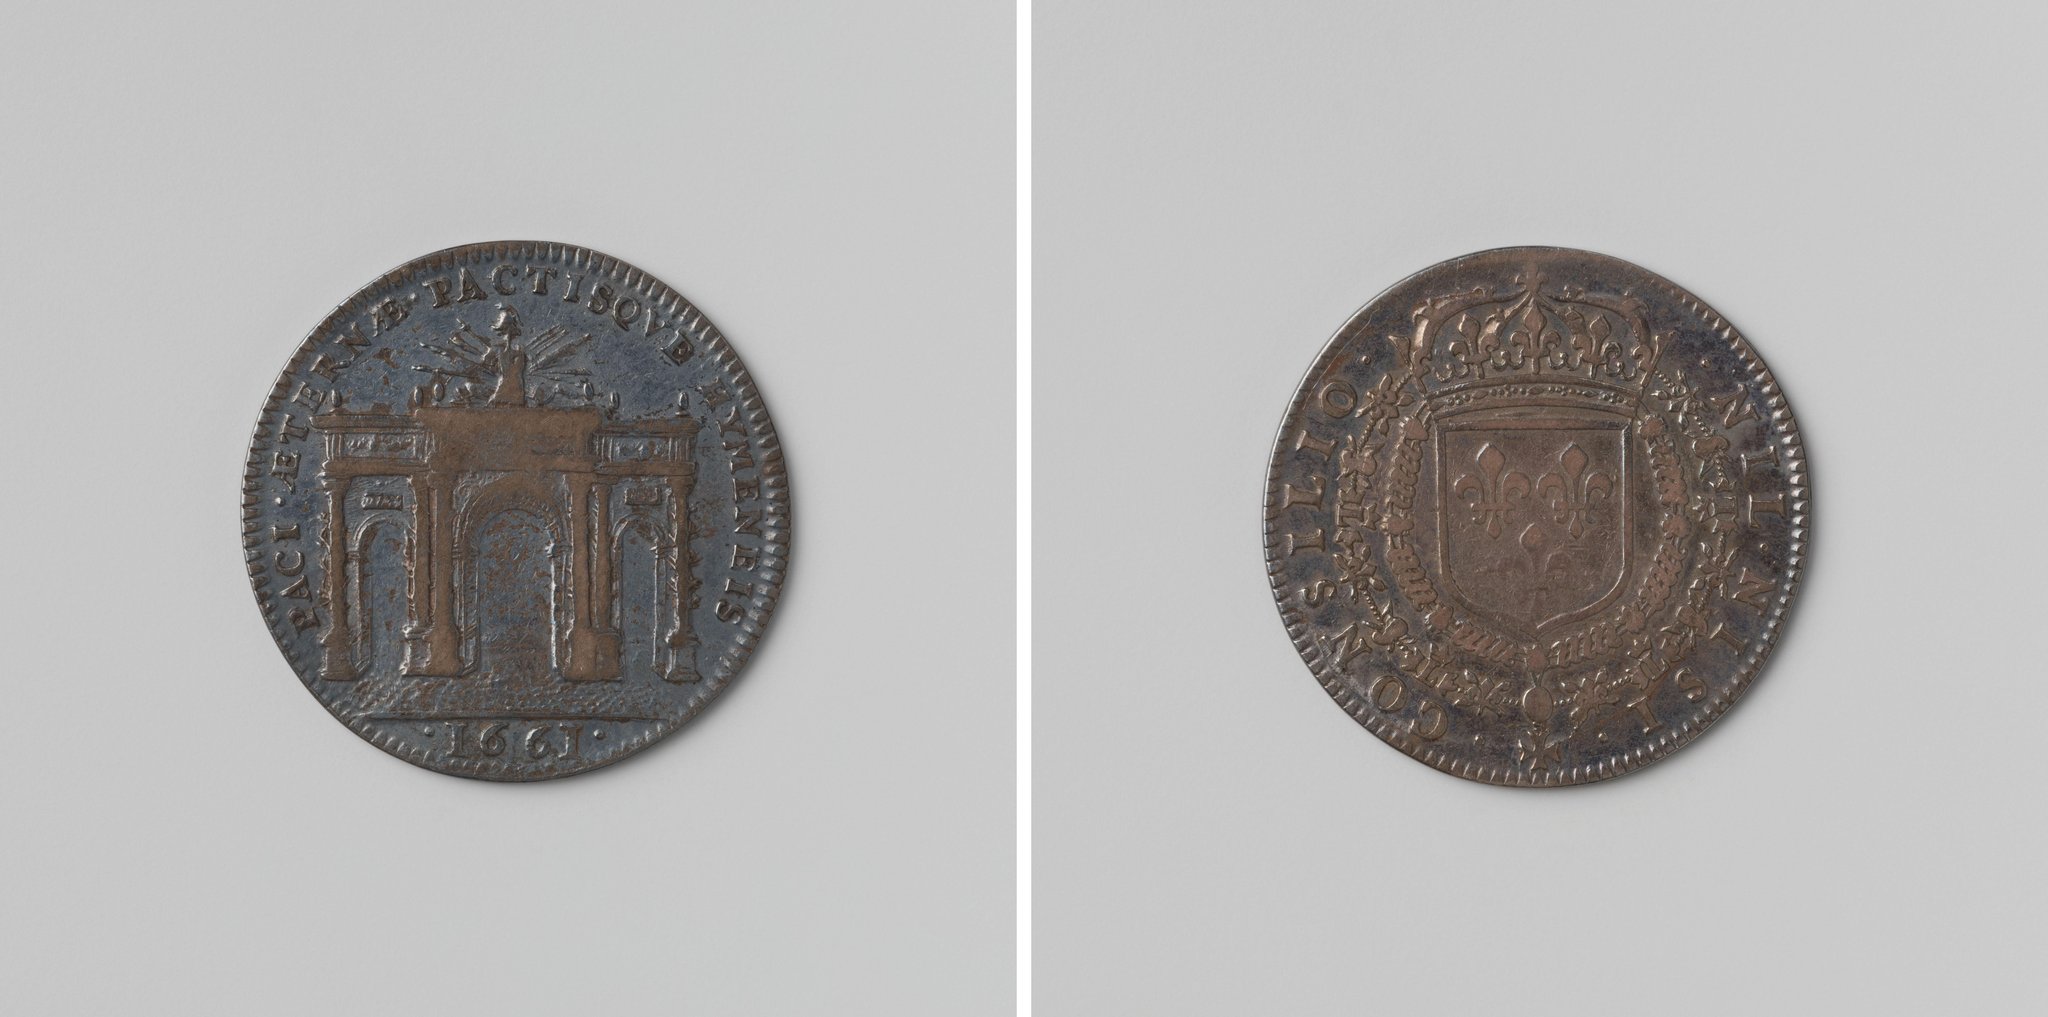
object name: jeton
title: Vrede van de Pyreneeën tussen Frankrijk en Spanje en huwelijk van Lodewijk XIV, koning van Frankrijk met Maria Theresia van Oostenrijk, rekenpenning geslagen op last van de Conseil d'Etat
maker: Anonymous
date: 1661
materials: silver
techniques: striking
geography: paris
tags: lodewijk xiv (koning van frankrijk), maria theresia (koningin van frankrijk), france, spain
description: Zilveren penning. Voorzijde: triomfboog, bekroond met stapel krijgstuig binnen omschrift; afsnede: jaartal. Keerzijde: gekroond wapenschild, omhangen met de orden van St. Michel en van de Heilige Geest binnen omschrift